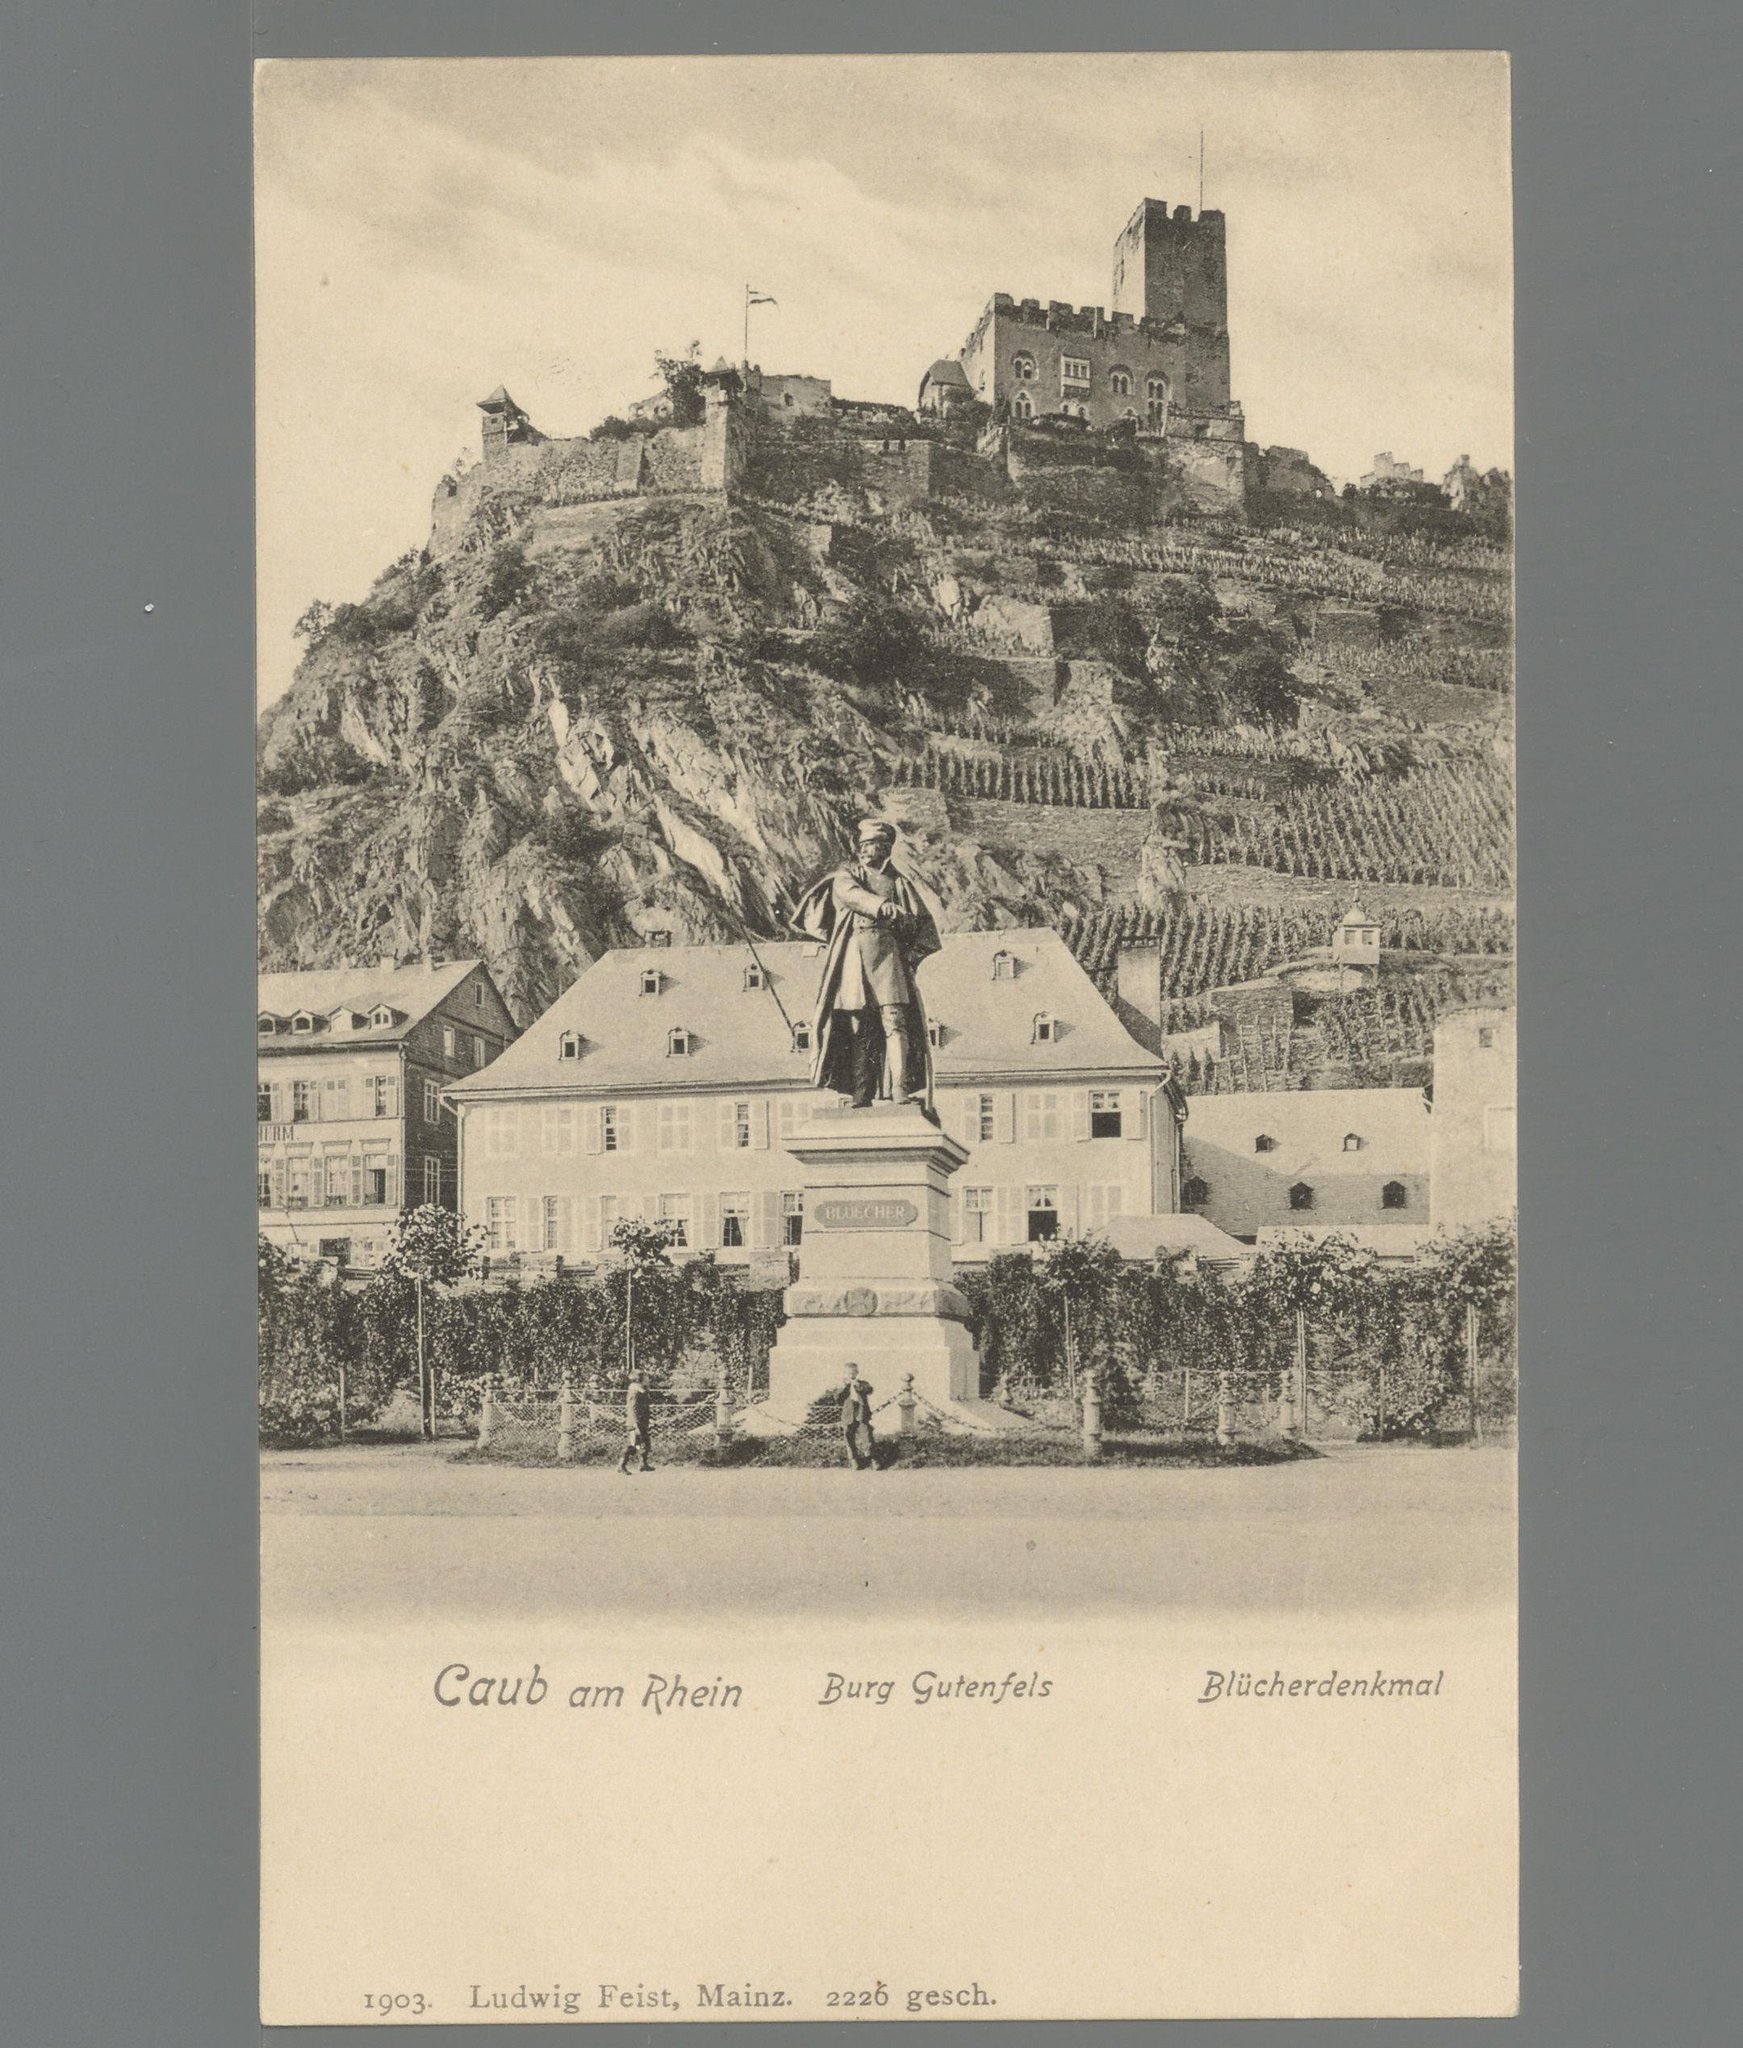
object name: ansichtkaart, prentbriefkaart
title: Caub am Rhein. Burg Gutenfels. Blücherdenkmal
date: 1903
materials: cardboard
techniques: photograph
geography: mainz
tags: castle, monument, statue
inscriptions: date